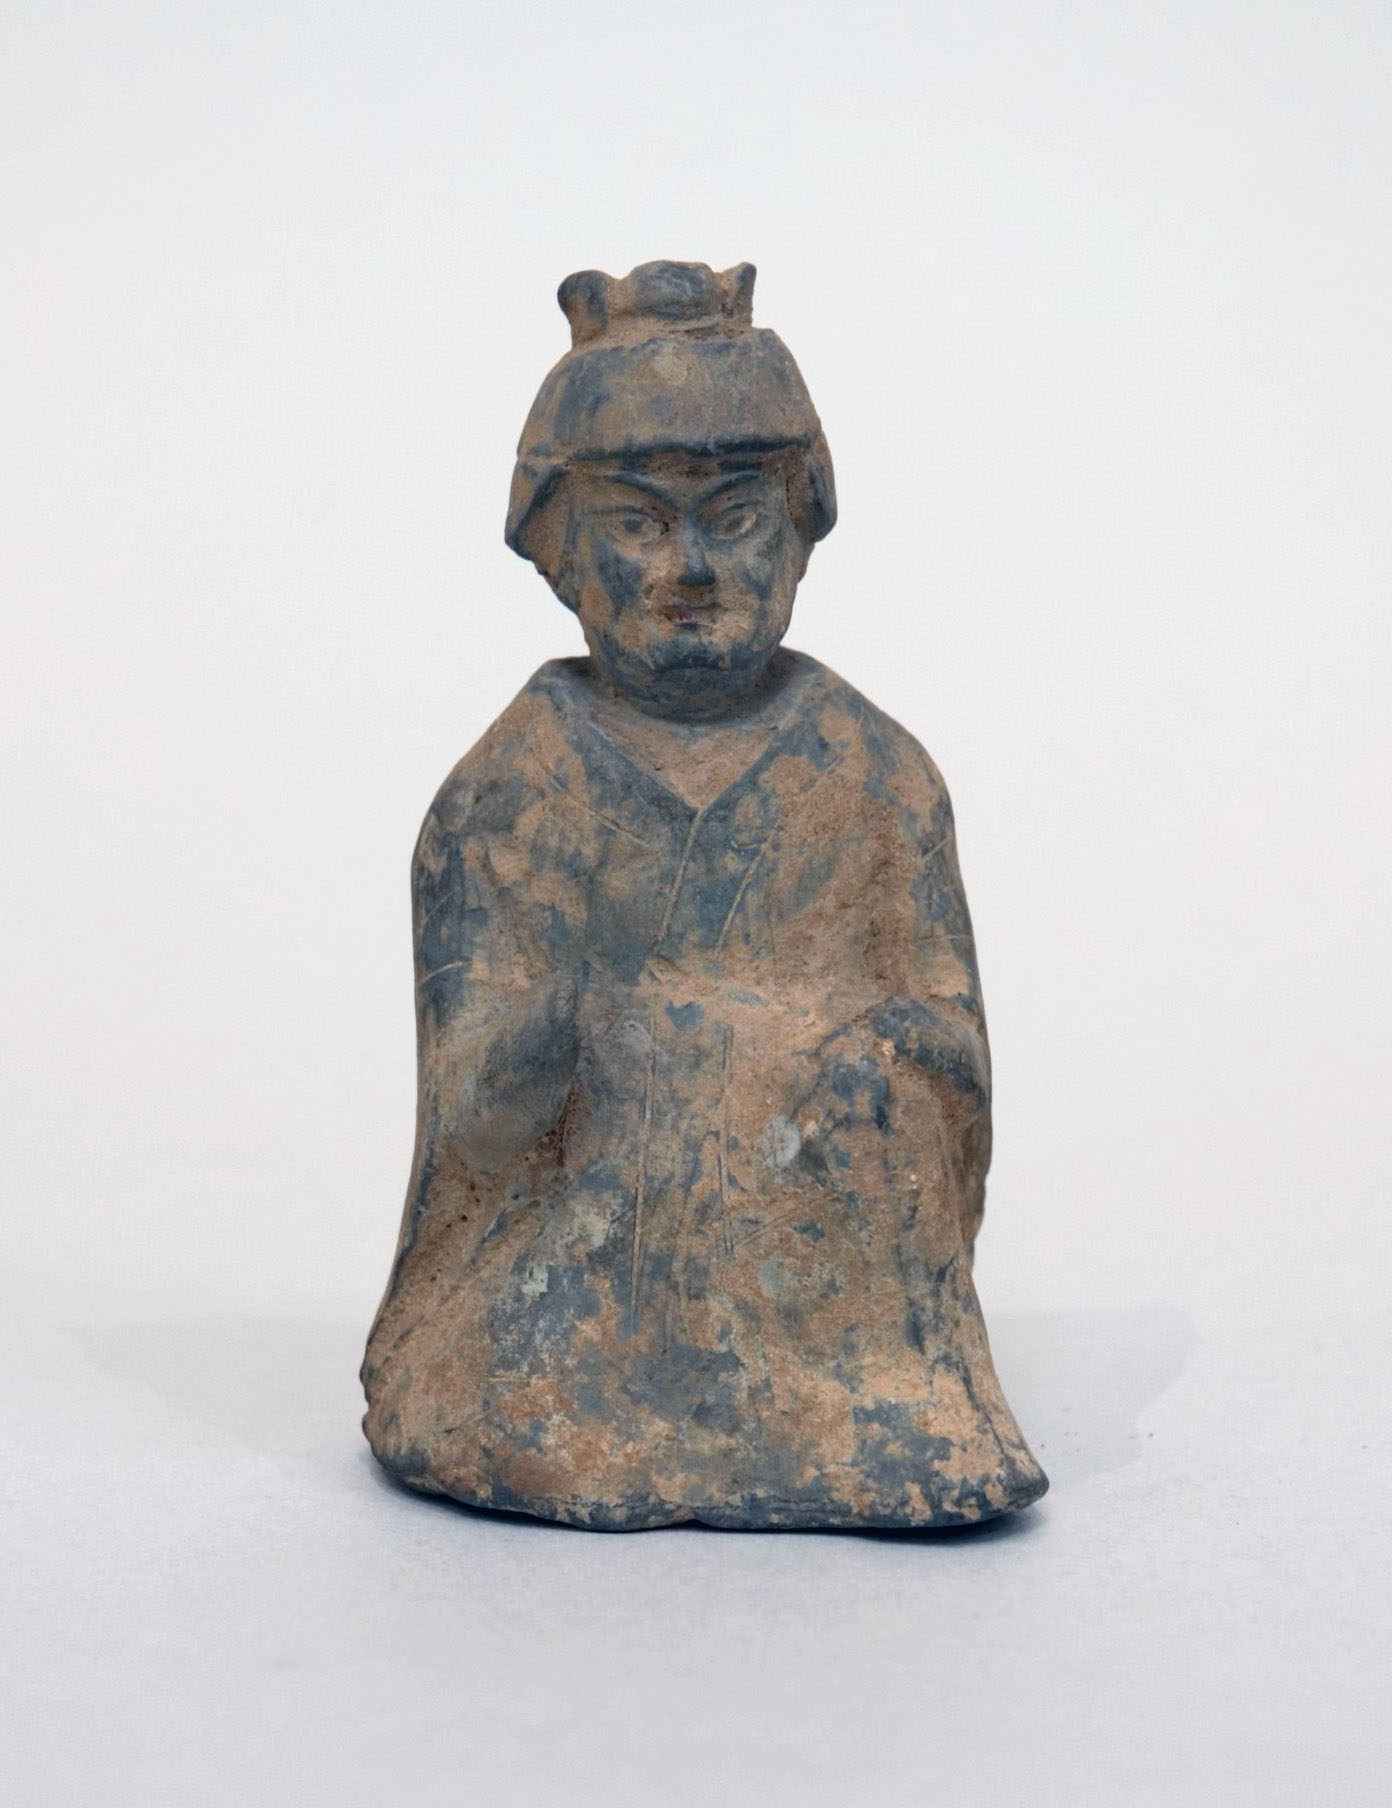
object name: figure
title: Figure of a seated man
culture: chinese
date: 401-500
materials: earthenware, pigment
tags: men